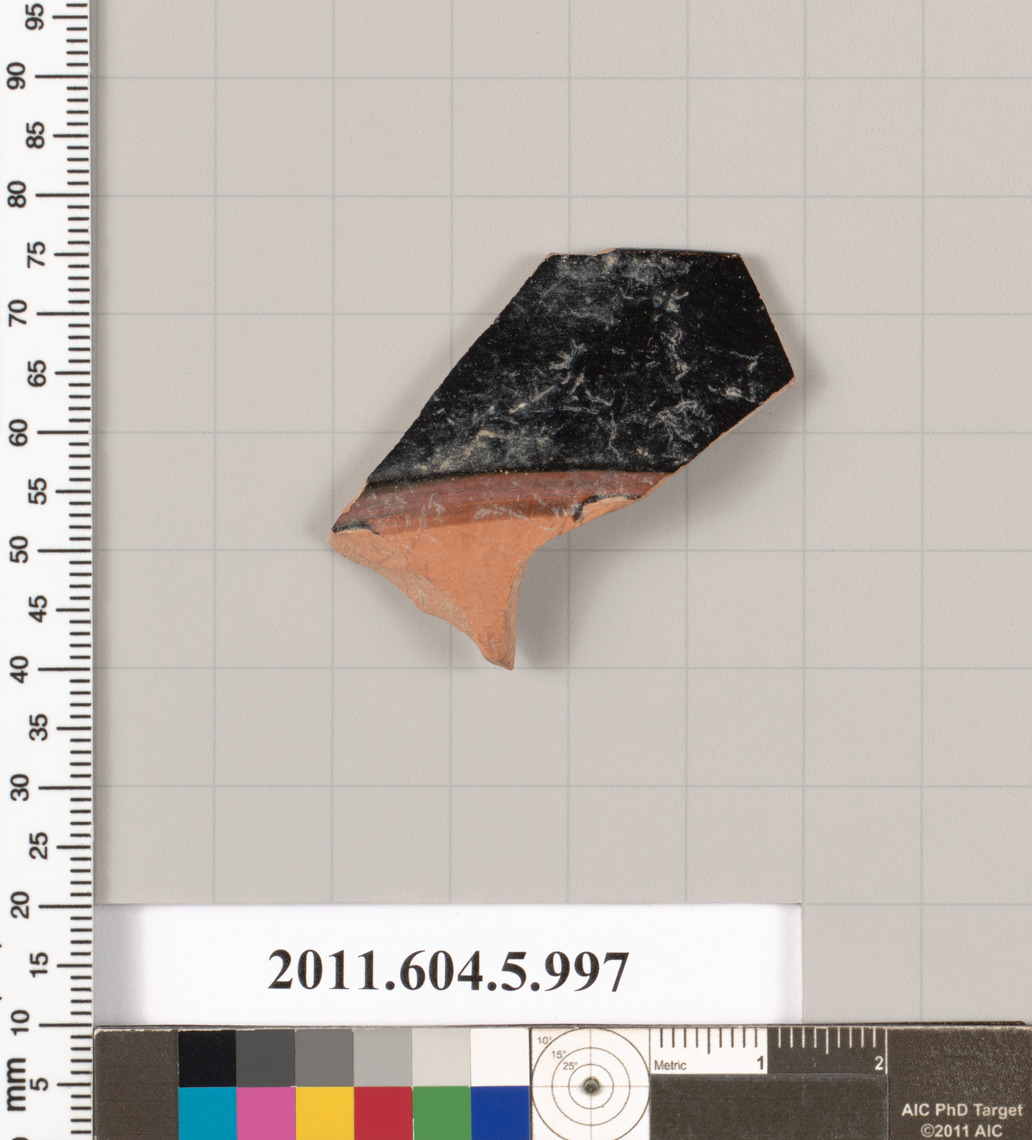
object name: kylix fragment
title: Terracotta rim fragment of a kylix (drinking cup)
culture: greek, attic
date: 600-401 BCE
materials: terracotta